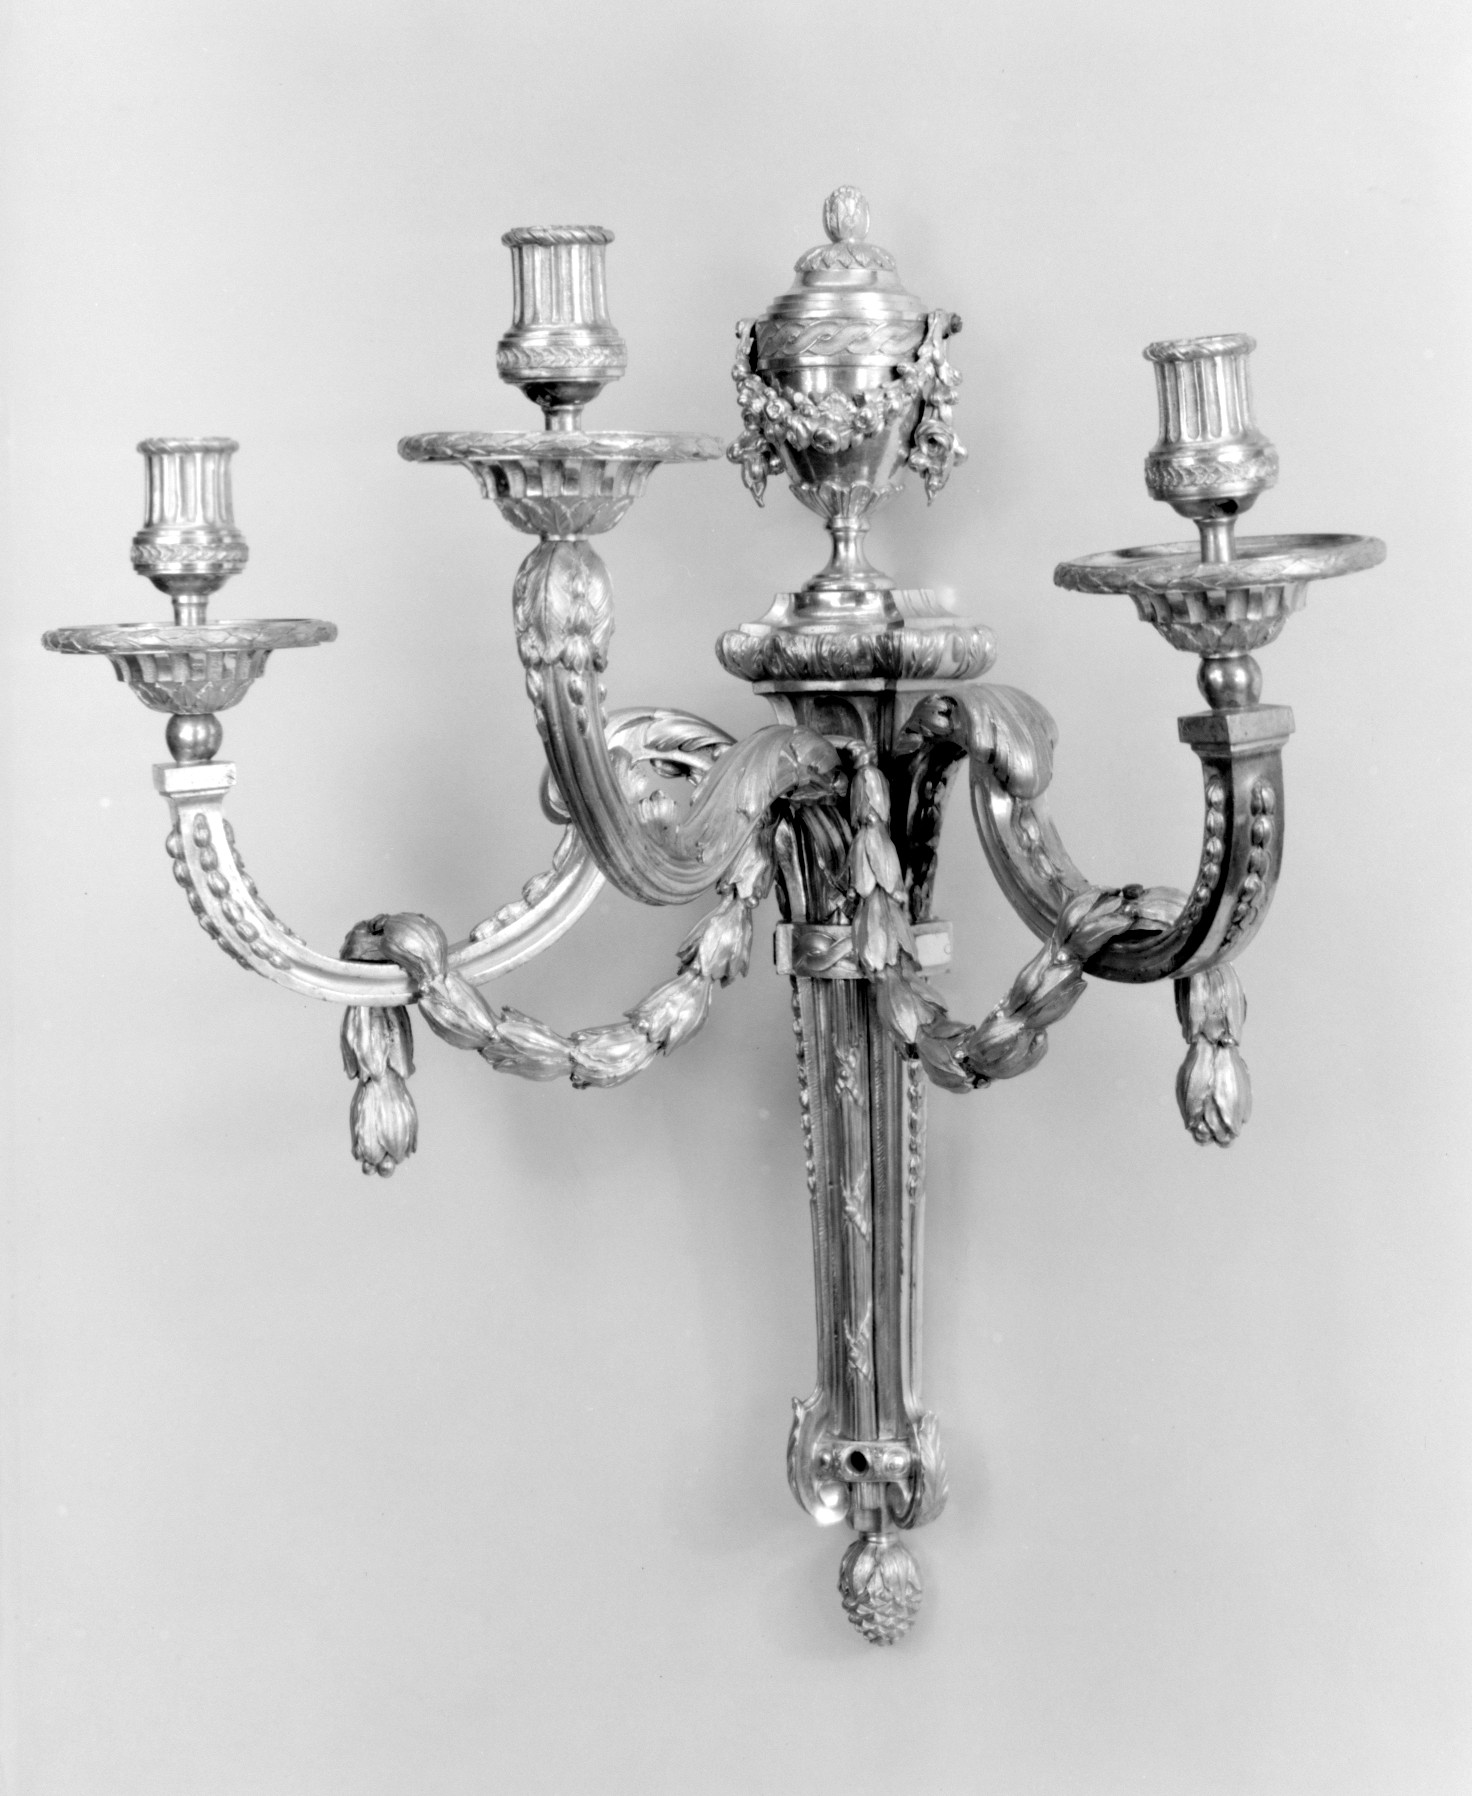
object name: wall sconce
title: Set of six wall sconces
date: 1774-1793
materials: gilt bronze